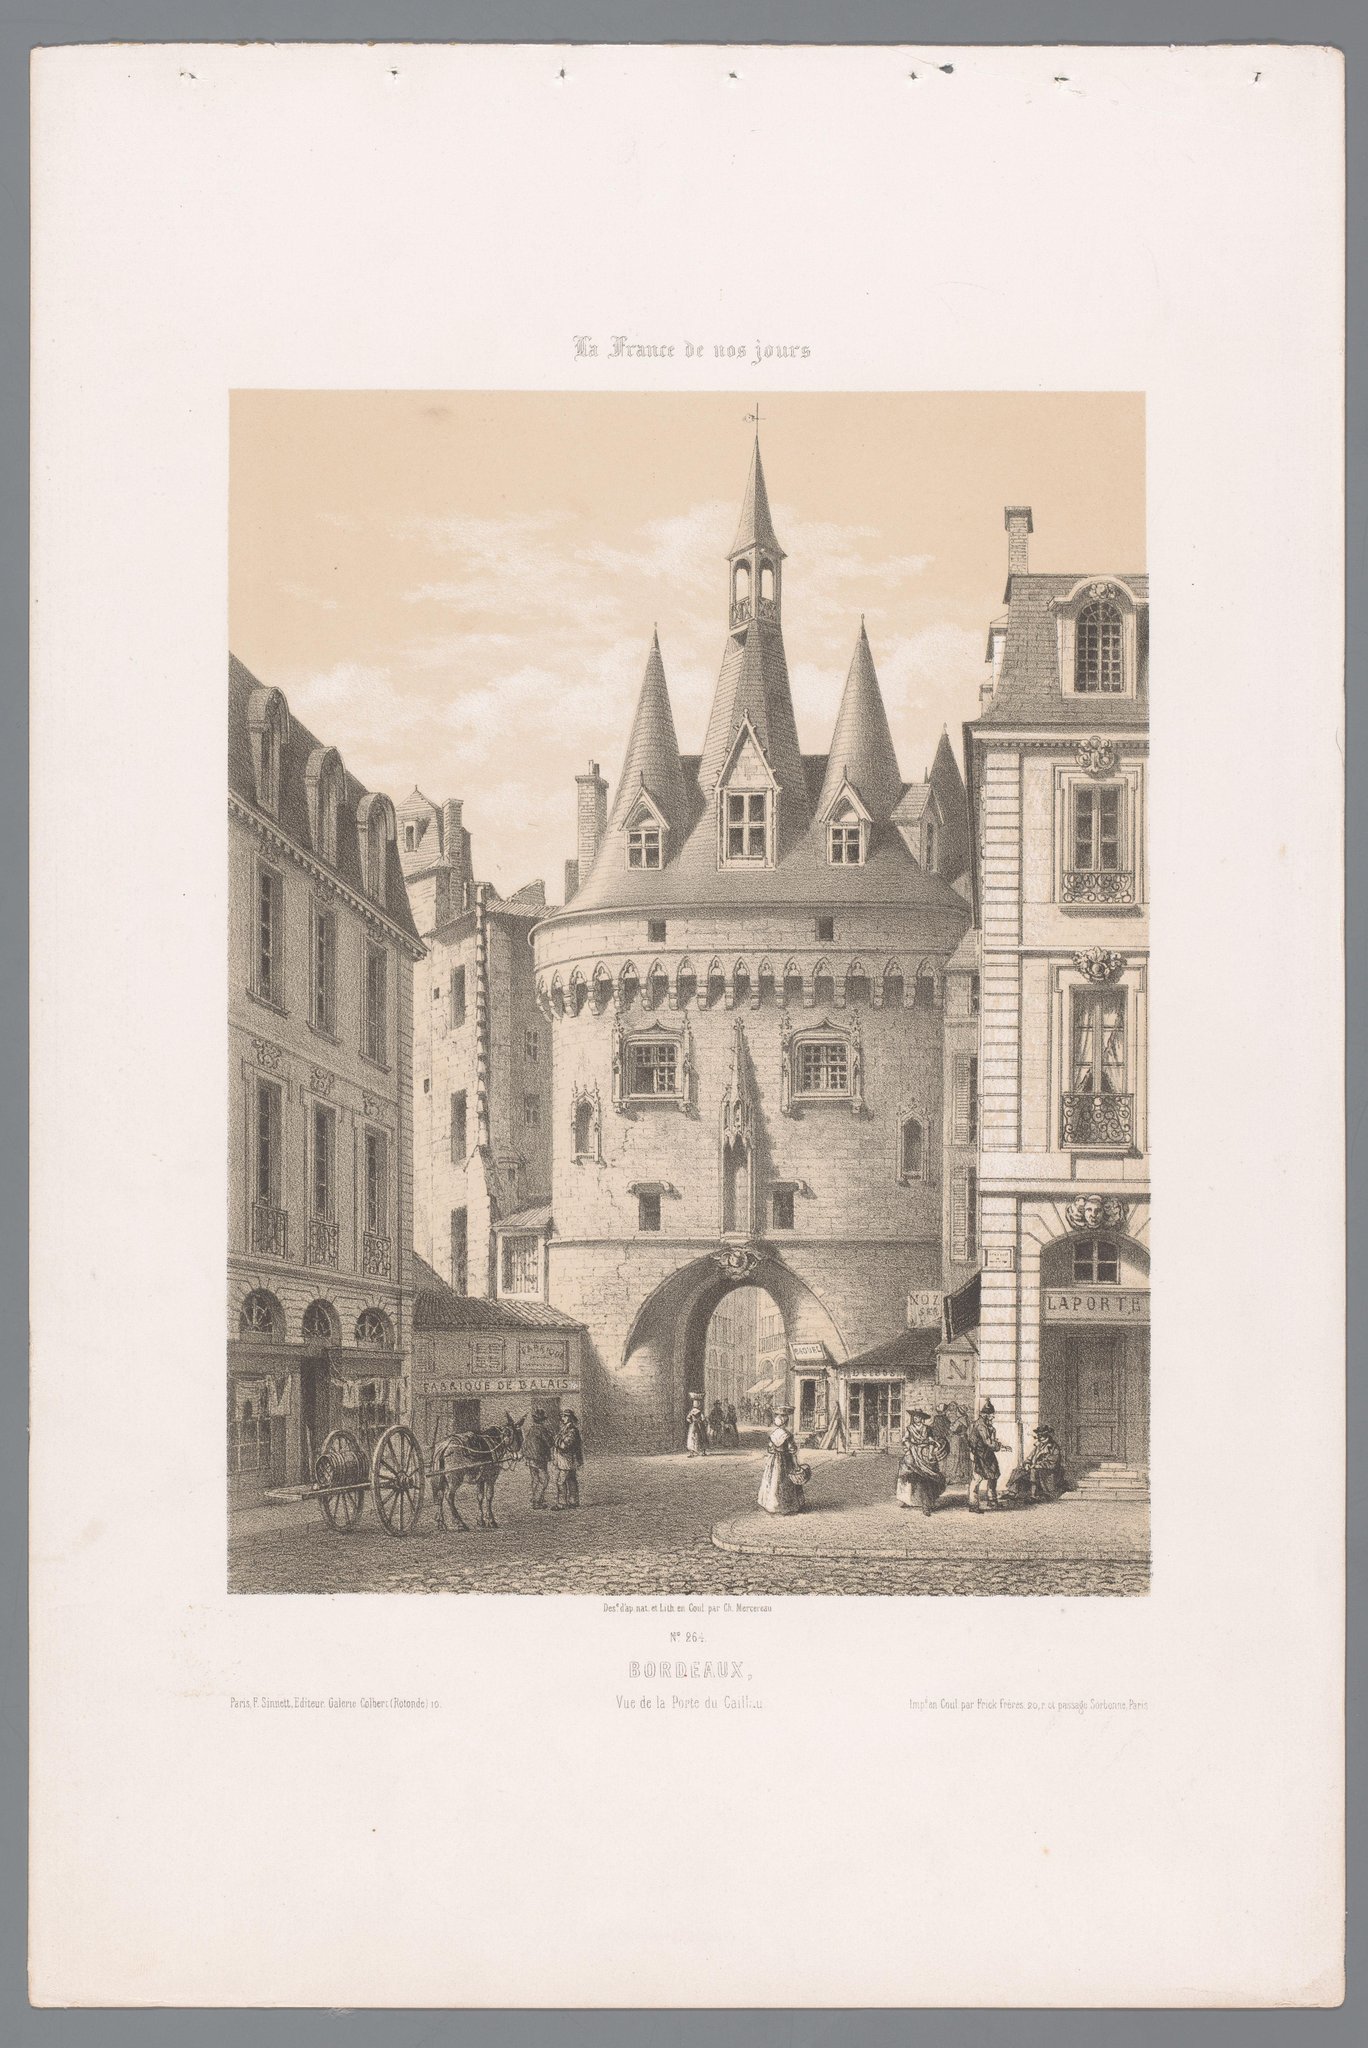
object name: print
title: Hedendaags Frankrijk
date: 1856-1874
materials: paper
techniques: tone lithography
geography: paris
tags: city-view, and landscape with man-made constructions, city-gate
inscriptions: collector's mark: Lugt 2228